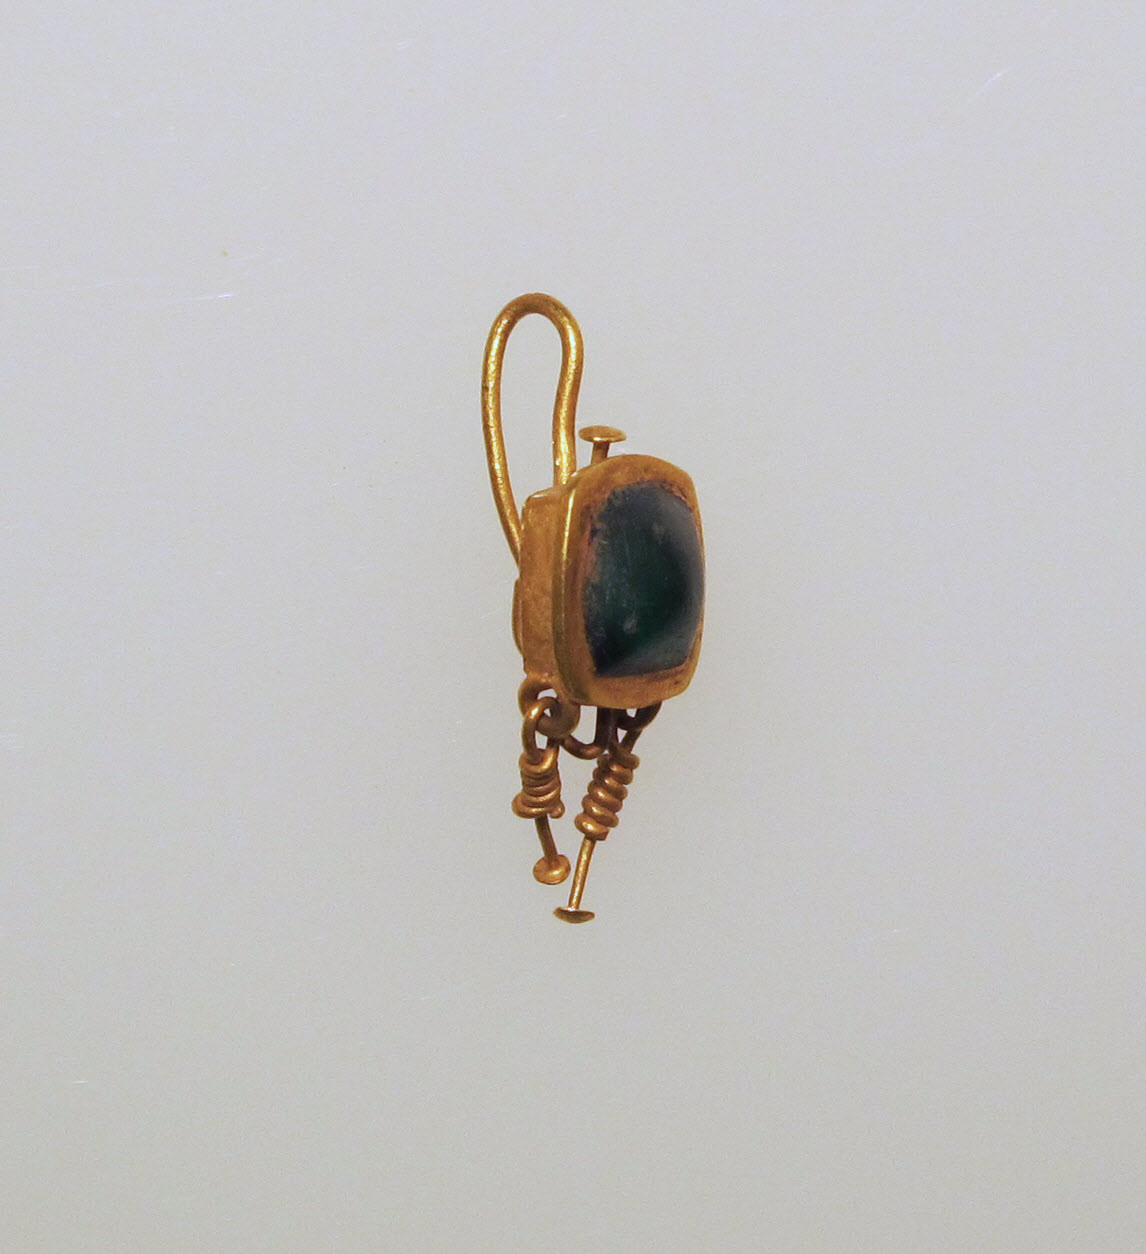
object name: earring hook type with emerald setting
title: Earring-hook type with emerald setting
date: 7000 BCE-330 CE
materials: gemstone, gold